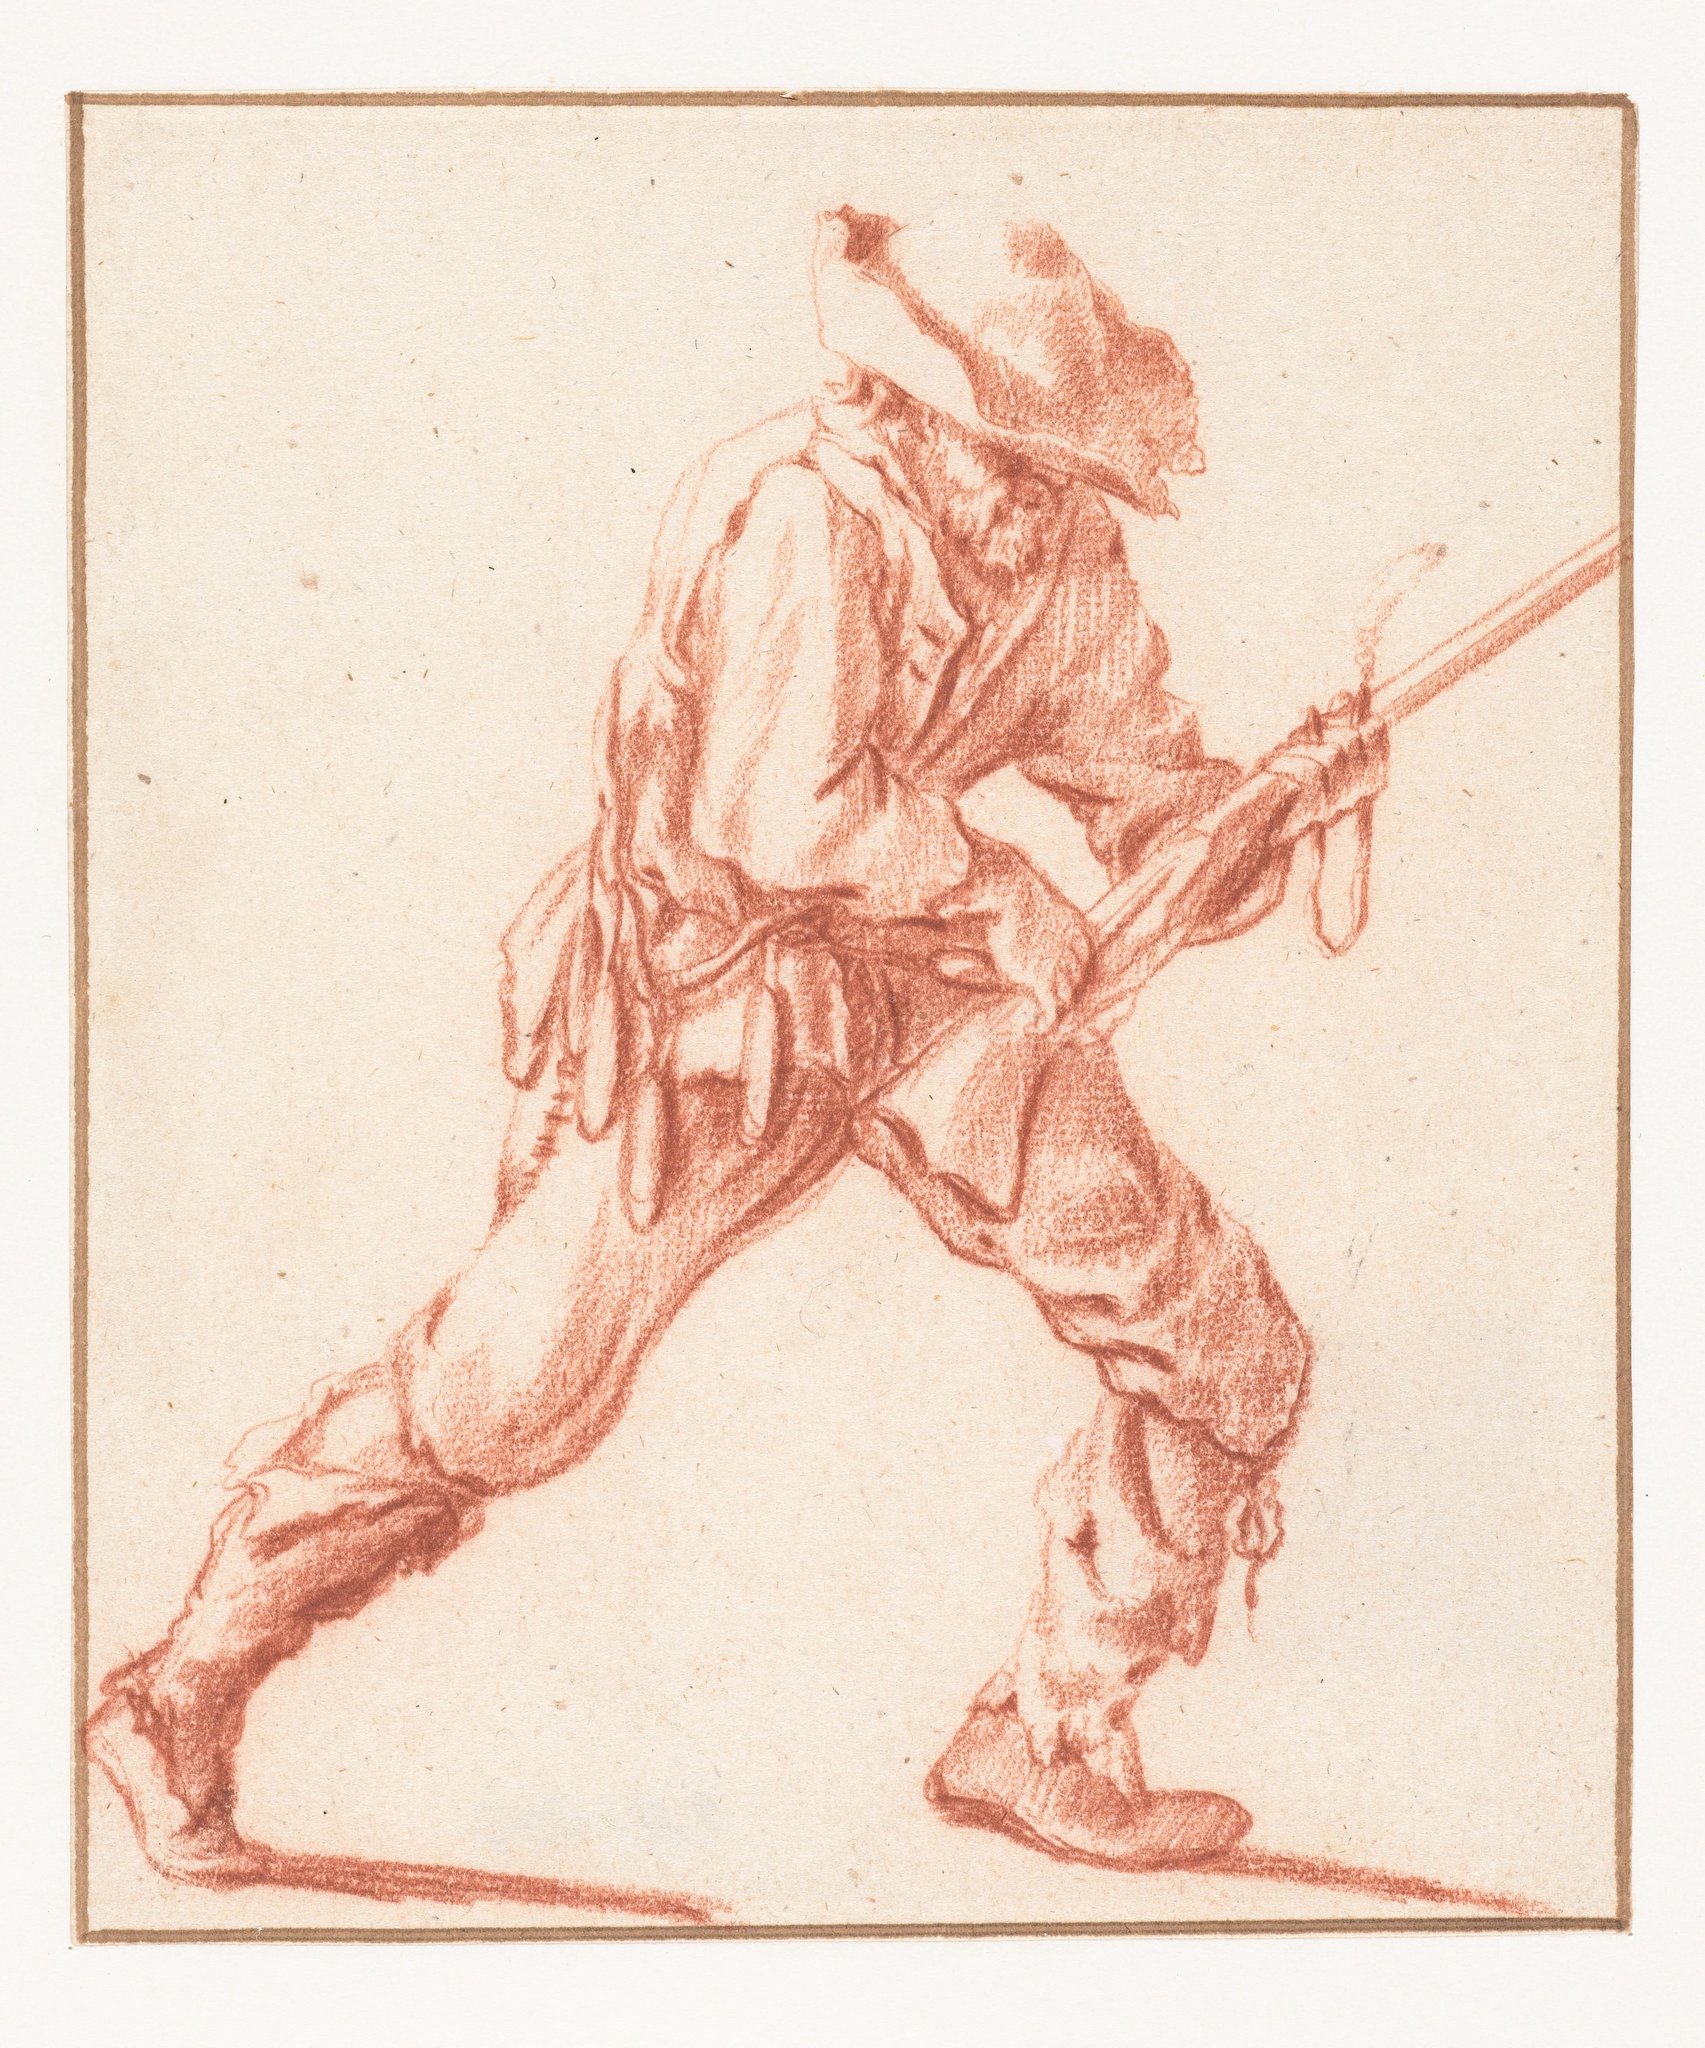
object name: drawing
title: Man Loading a Rifle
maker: Anonymous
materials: chalk, paper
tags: firearms: rifle (+ handling of weapons)